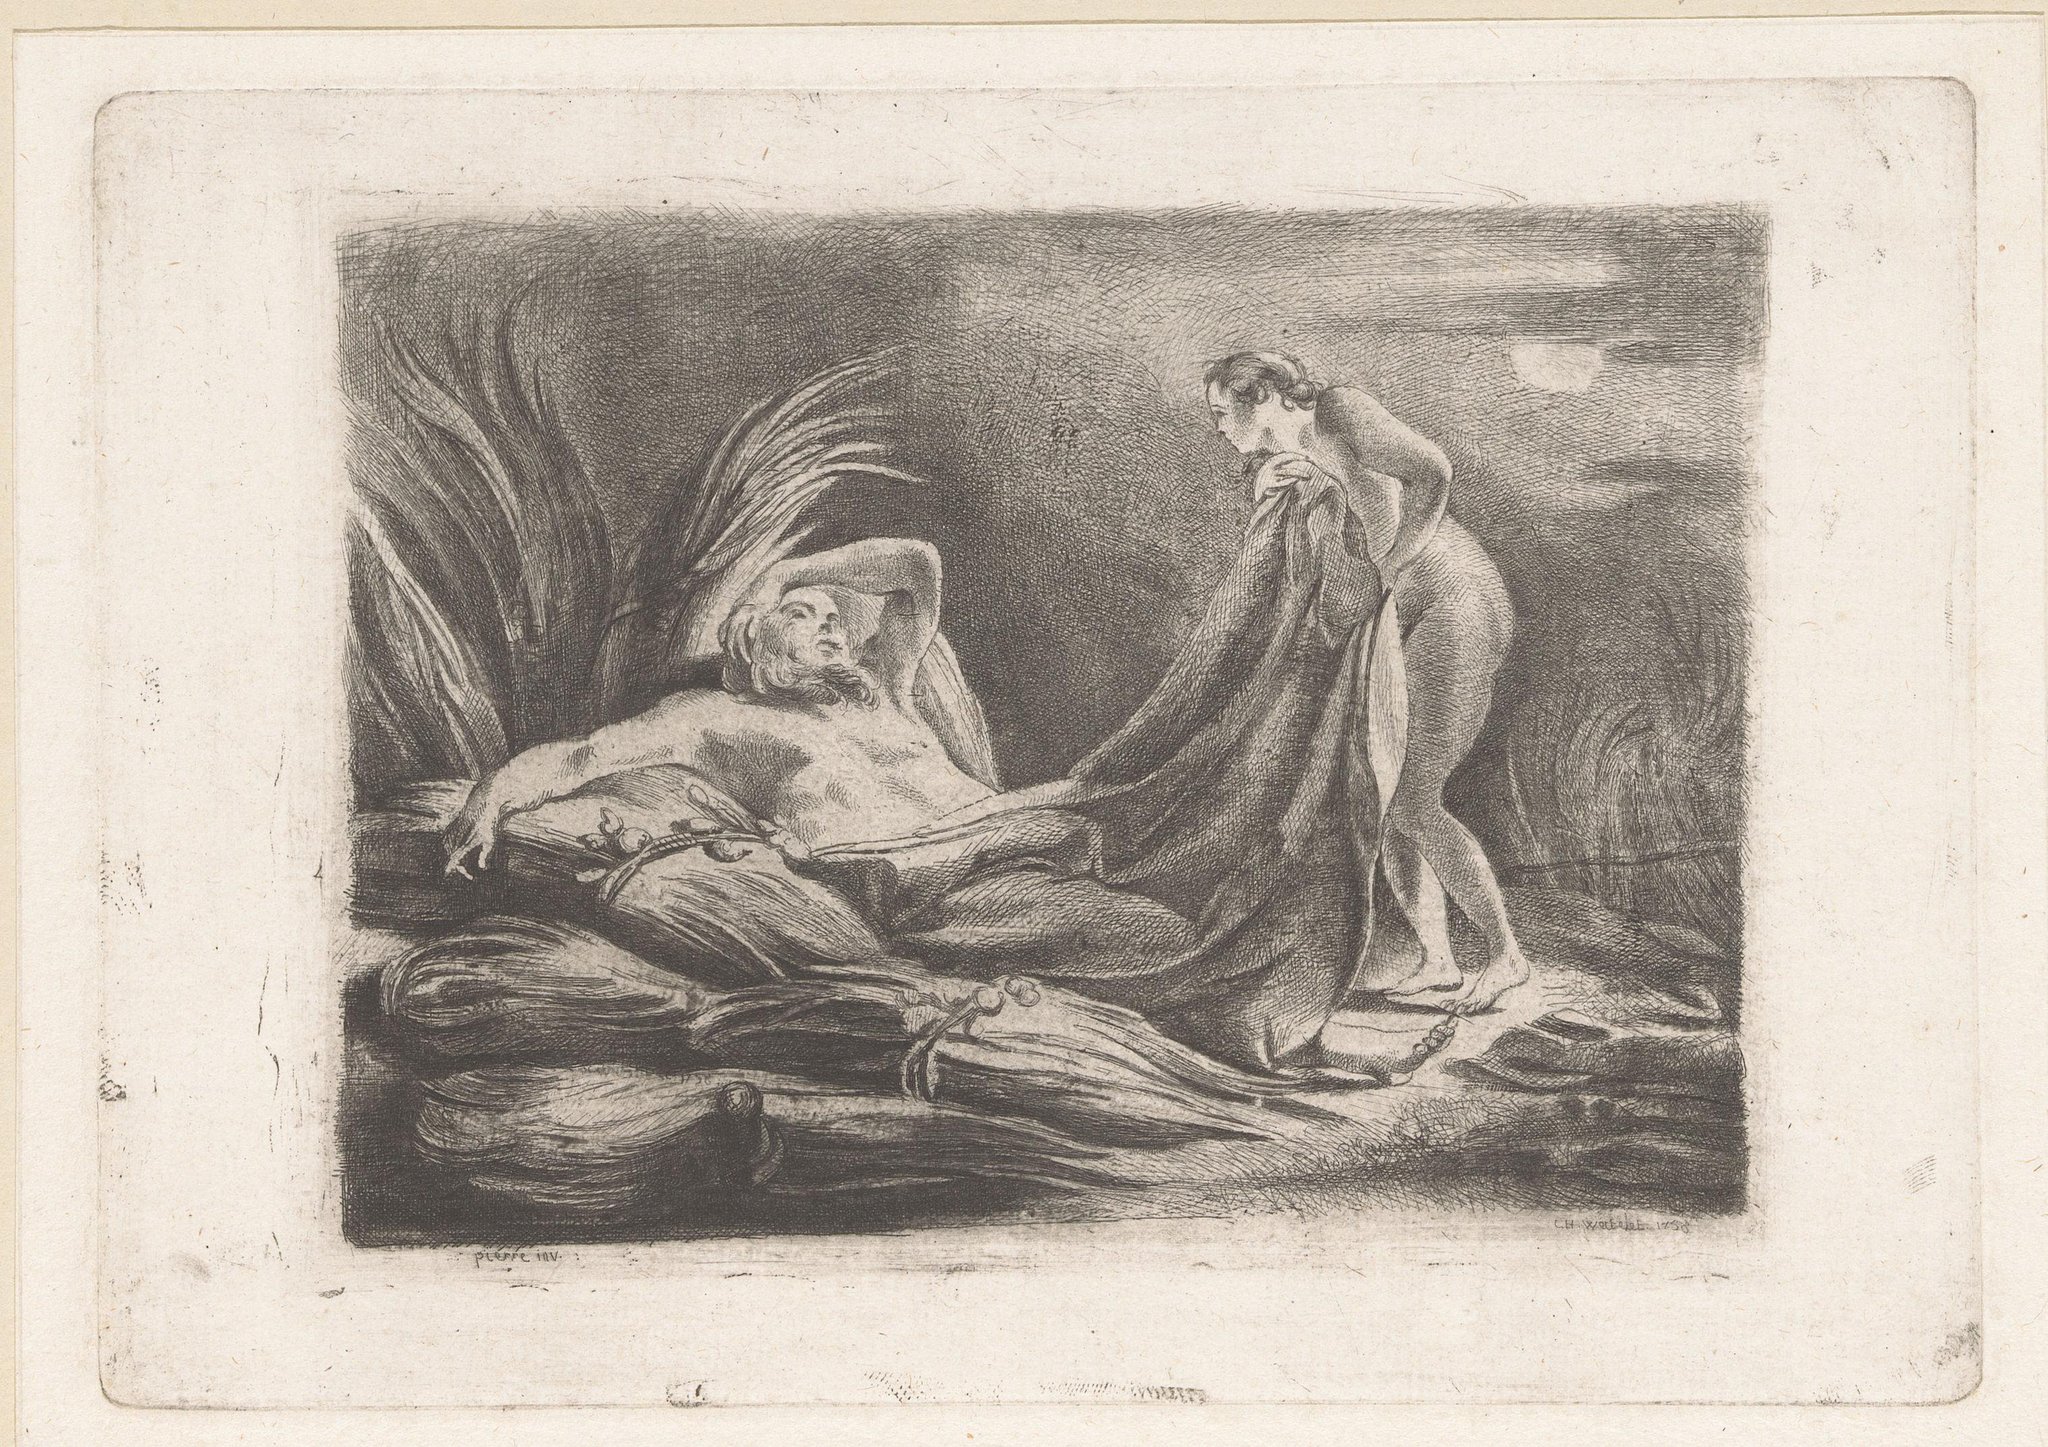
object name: print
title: Naakte jonge vrouw voor een oude man op korenschoven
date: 1758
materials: paper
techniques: etching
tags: (showing oneself) undressed, quasi-nude, cereal, grain, corn (grass with grains, grown for food, e.g.: wheat, rice, rye, oats, maize, buckwheat, millet), night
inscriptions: collector's mark: Lugt 240